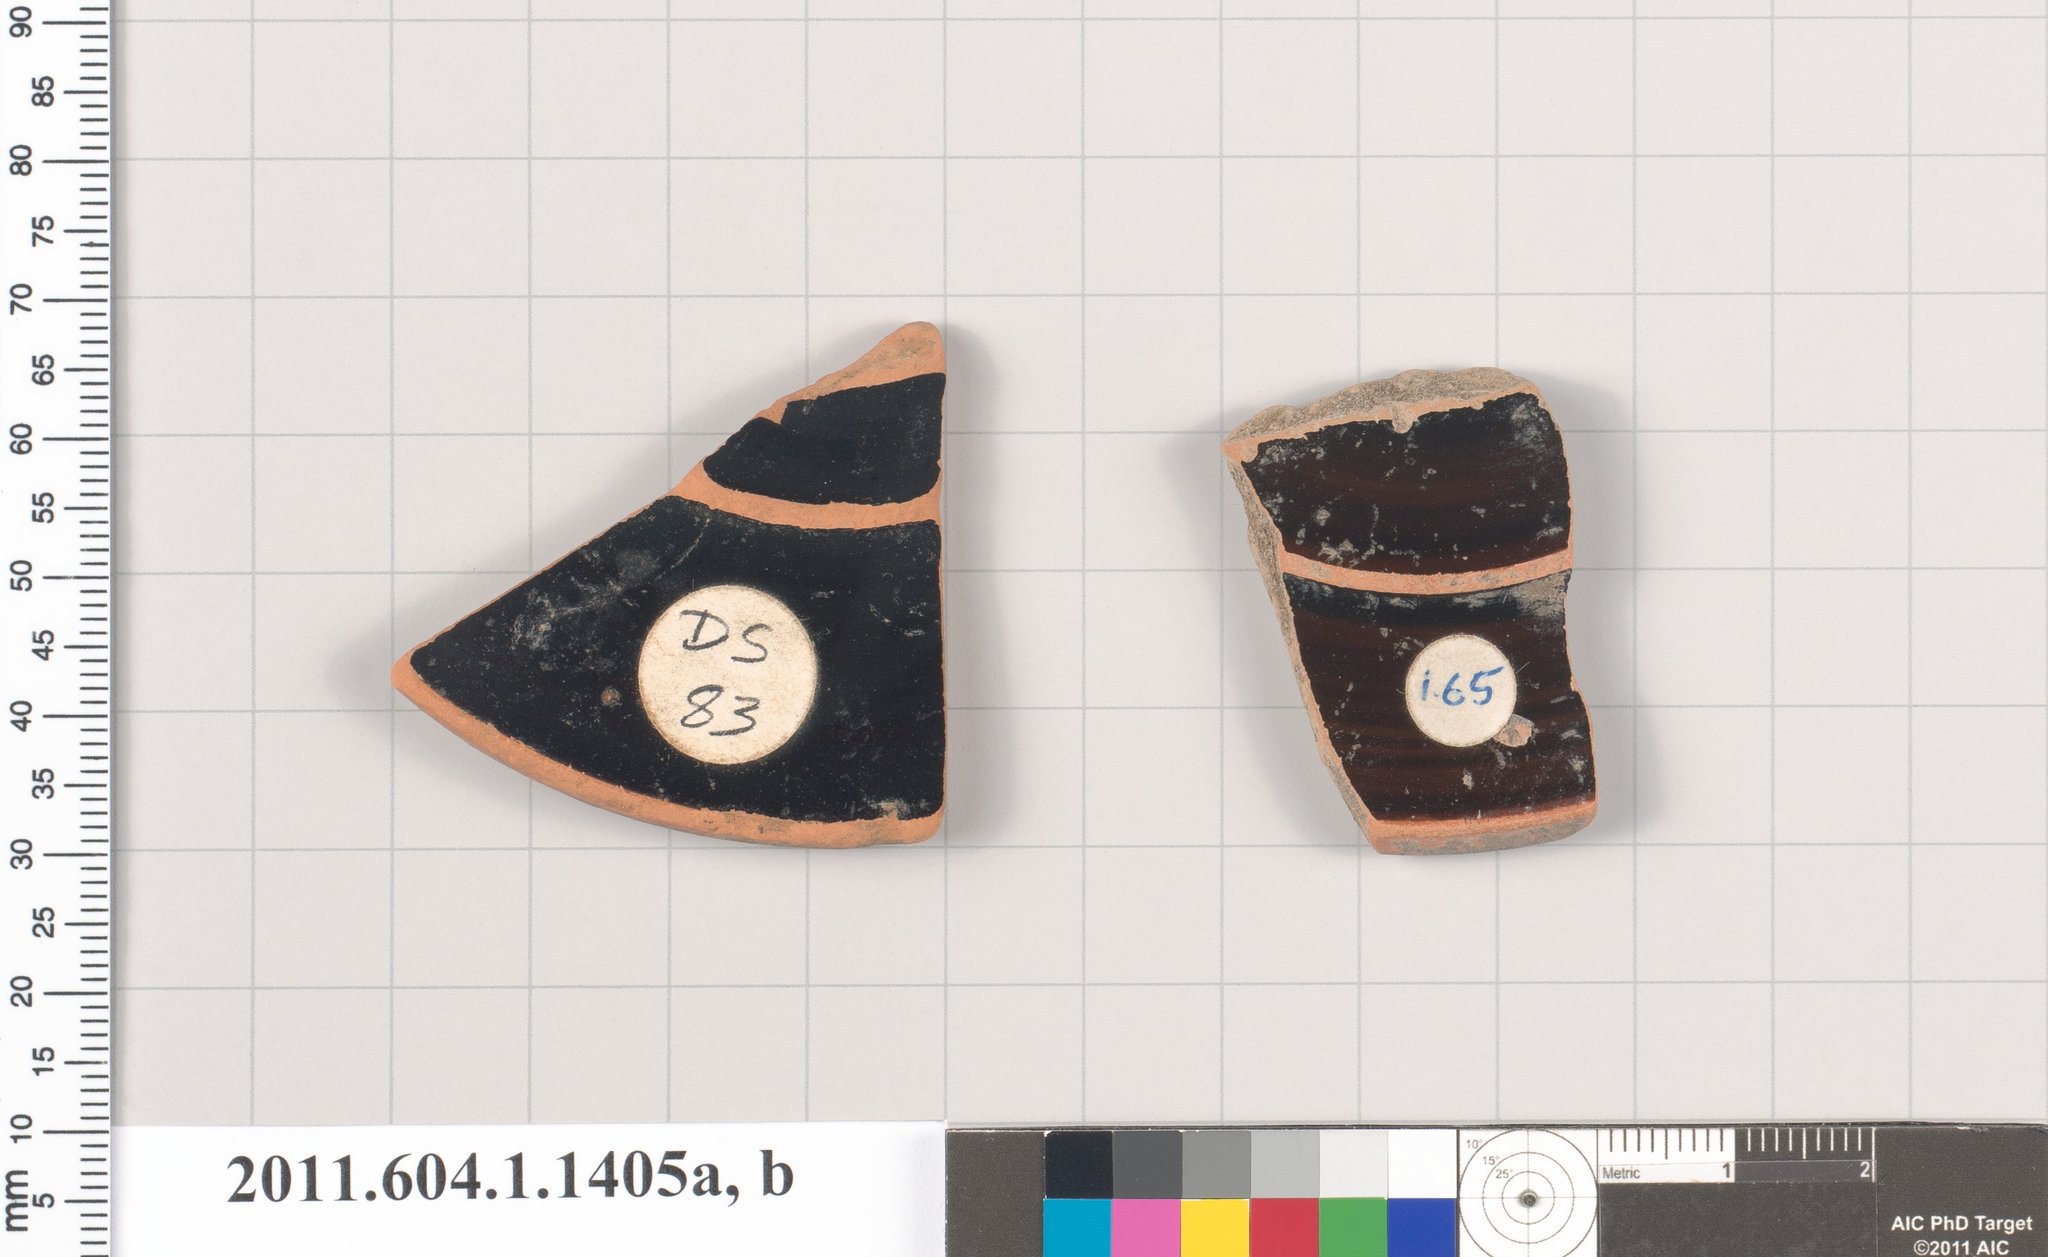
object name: kylix fragment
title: Terracotta fragments of kylikes (drinking cups)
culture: greek, attic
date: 500-401 BCE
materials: terracotta